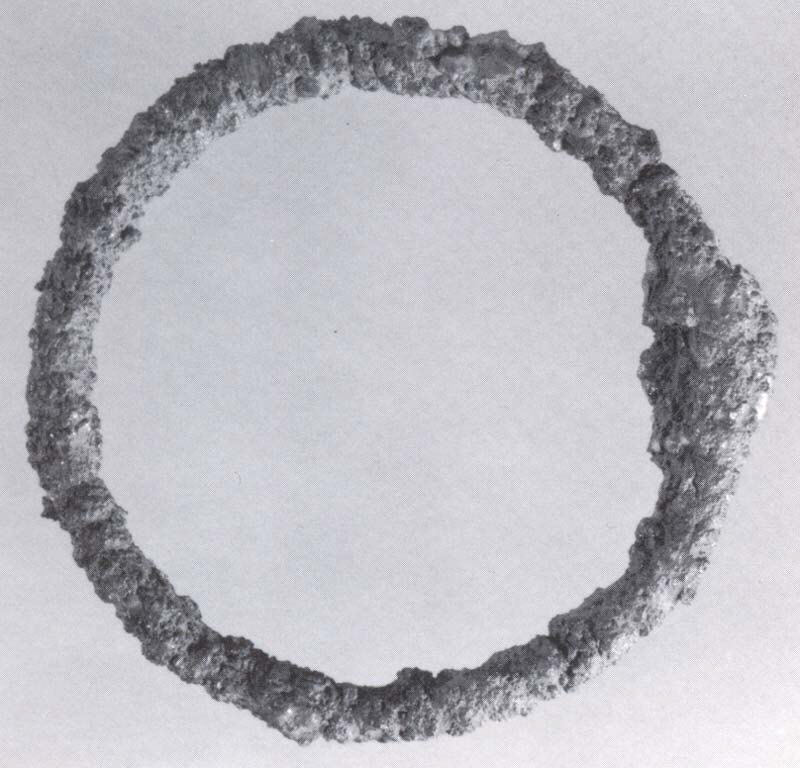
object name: bracelet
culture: iranian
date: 900-801 BCE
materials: iron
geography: iran